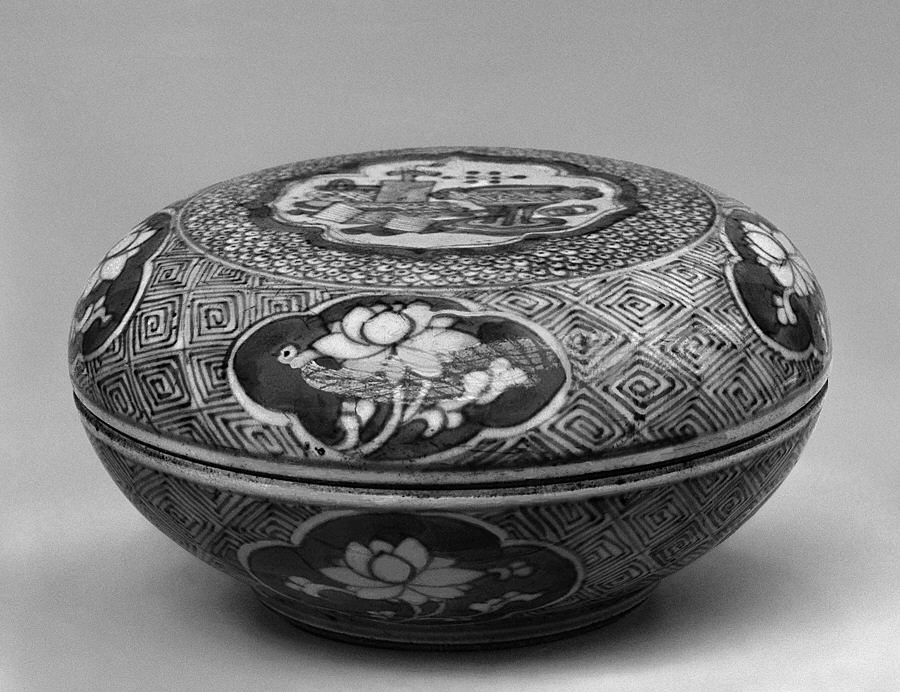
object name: covered box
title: Box with Cover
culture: chinese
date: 1662-1722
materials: porcelain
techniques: underglaze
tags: lotuses